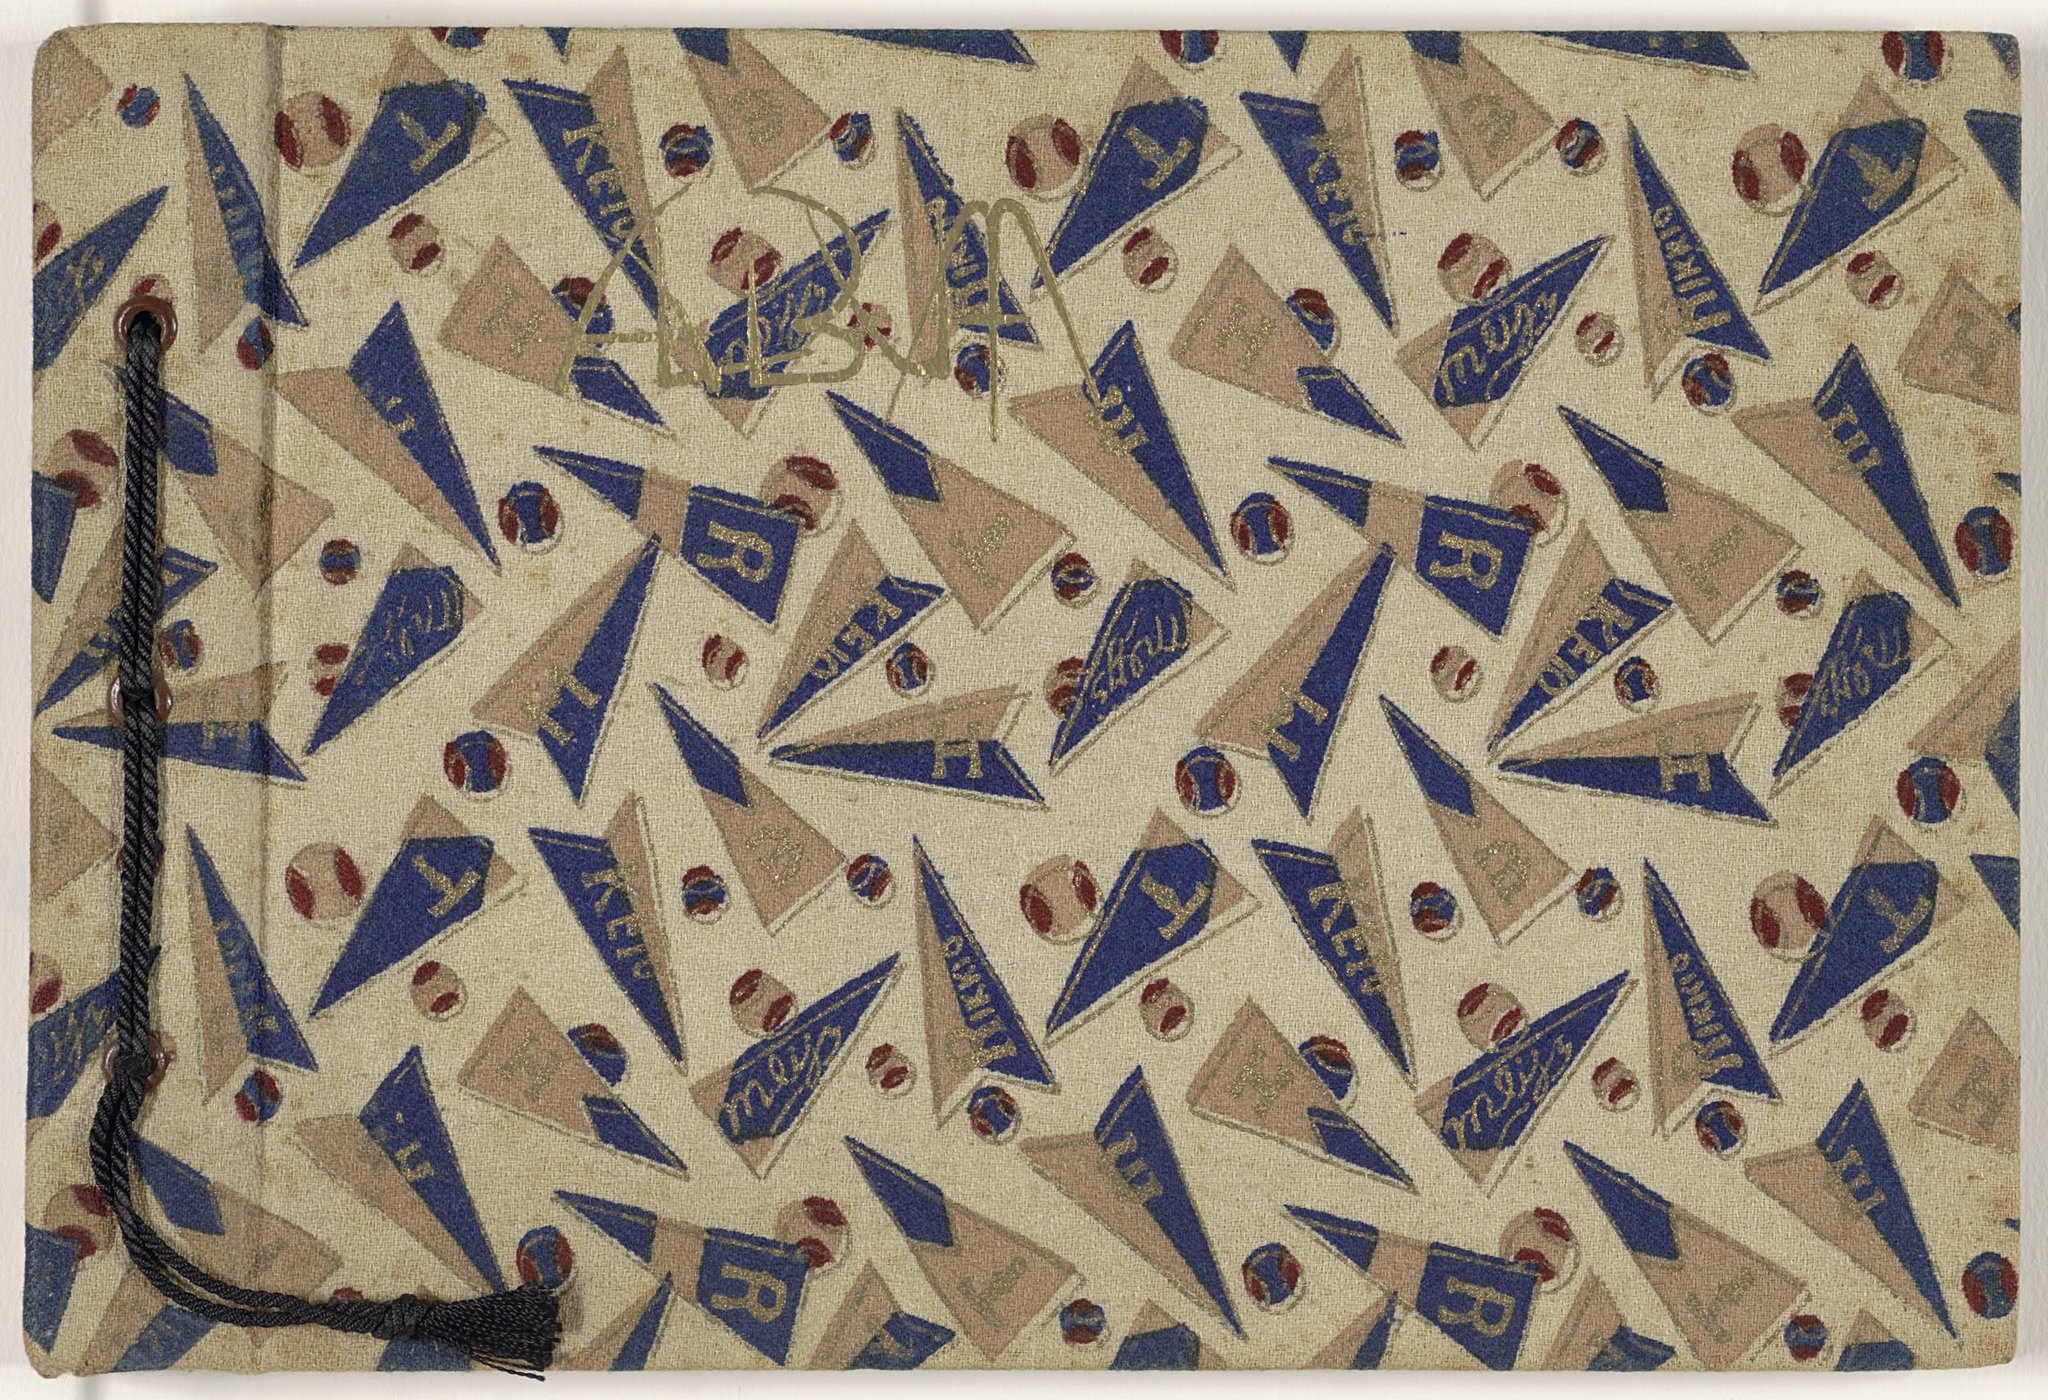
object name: photograph album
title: Album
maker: Anonymous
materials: cardboard, paper, metal, photographic support, fiber, textile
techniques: gelatin silver print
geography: dutch east indies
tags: administrative bodies, education, colonial government, dutch east indies, the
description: Fotoalbum aangeboden aan de resident der Lampongse districten F.J. Junius door studerende ambtenaren van de bestuursschool te Batavia op 14 april 1932, vermoedelijk ter gelegenheid van het vertrek van Junius. Het album heeft een crèmekleurige omslag met daarop vaantjes in blauw en beige. Op de vaantjes staan in goudopdruk woorden, onder andere 'KEIO', 'meijs'en 'Rikkio'. De albumbladen zijn met behulp van een door metalen oogjes geregen touw vastgezet. Op de voorzijde in goudopdruk het woord 'Album'. Het album bevat 23 donkerbruine albumbladen, gescheiden door pergamijn. De in totaal 17 foto's zijn voorzien van een handgeschreven onderschrift.